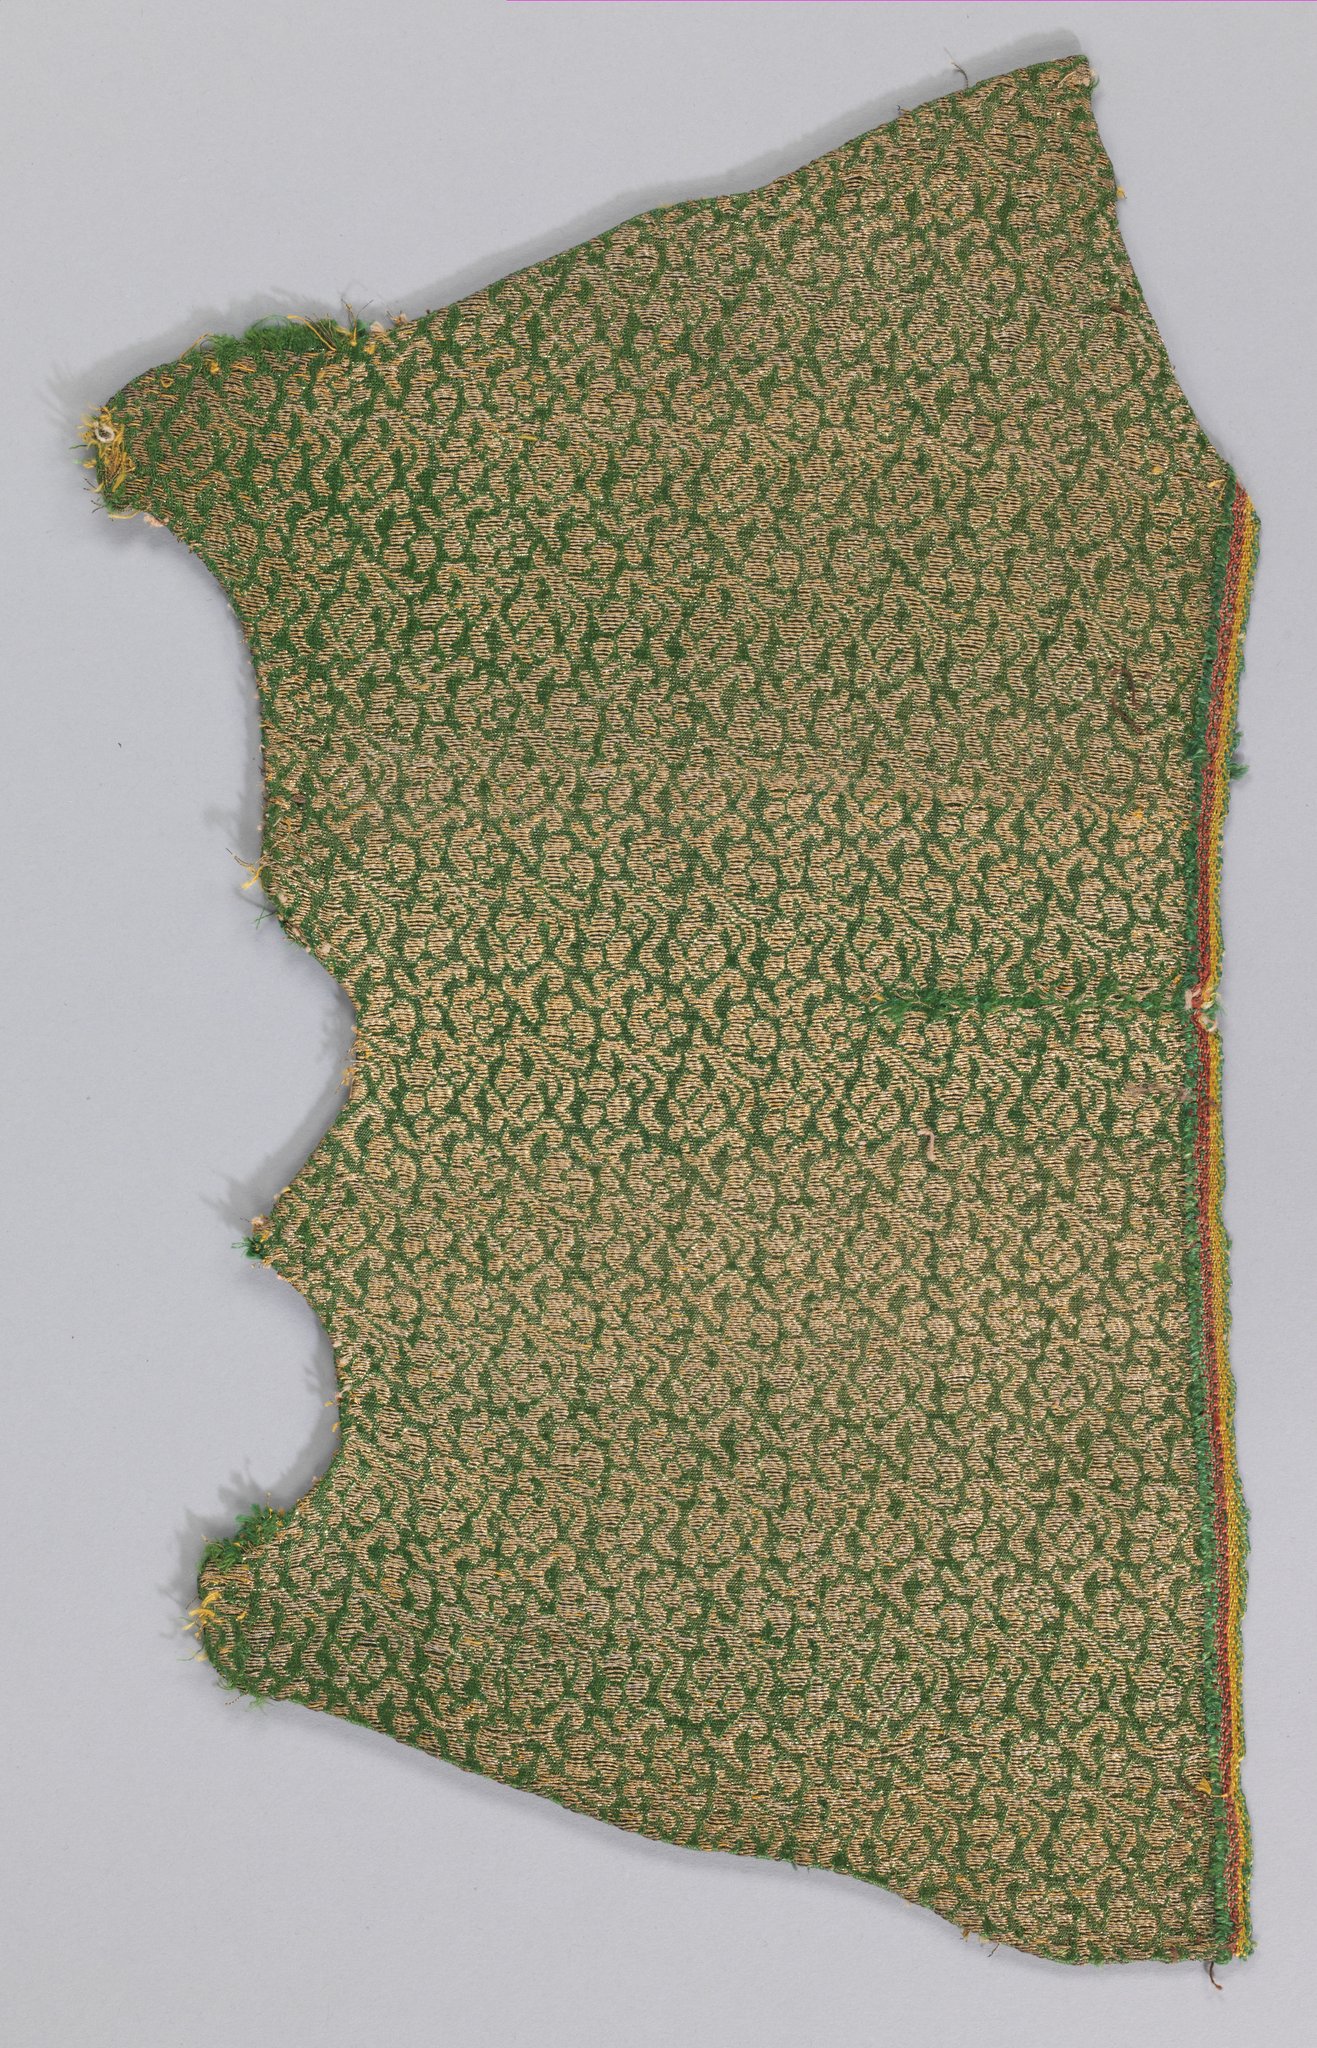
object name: fragment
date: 1601-1800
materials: metal thread, silk